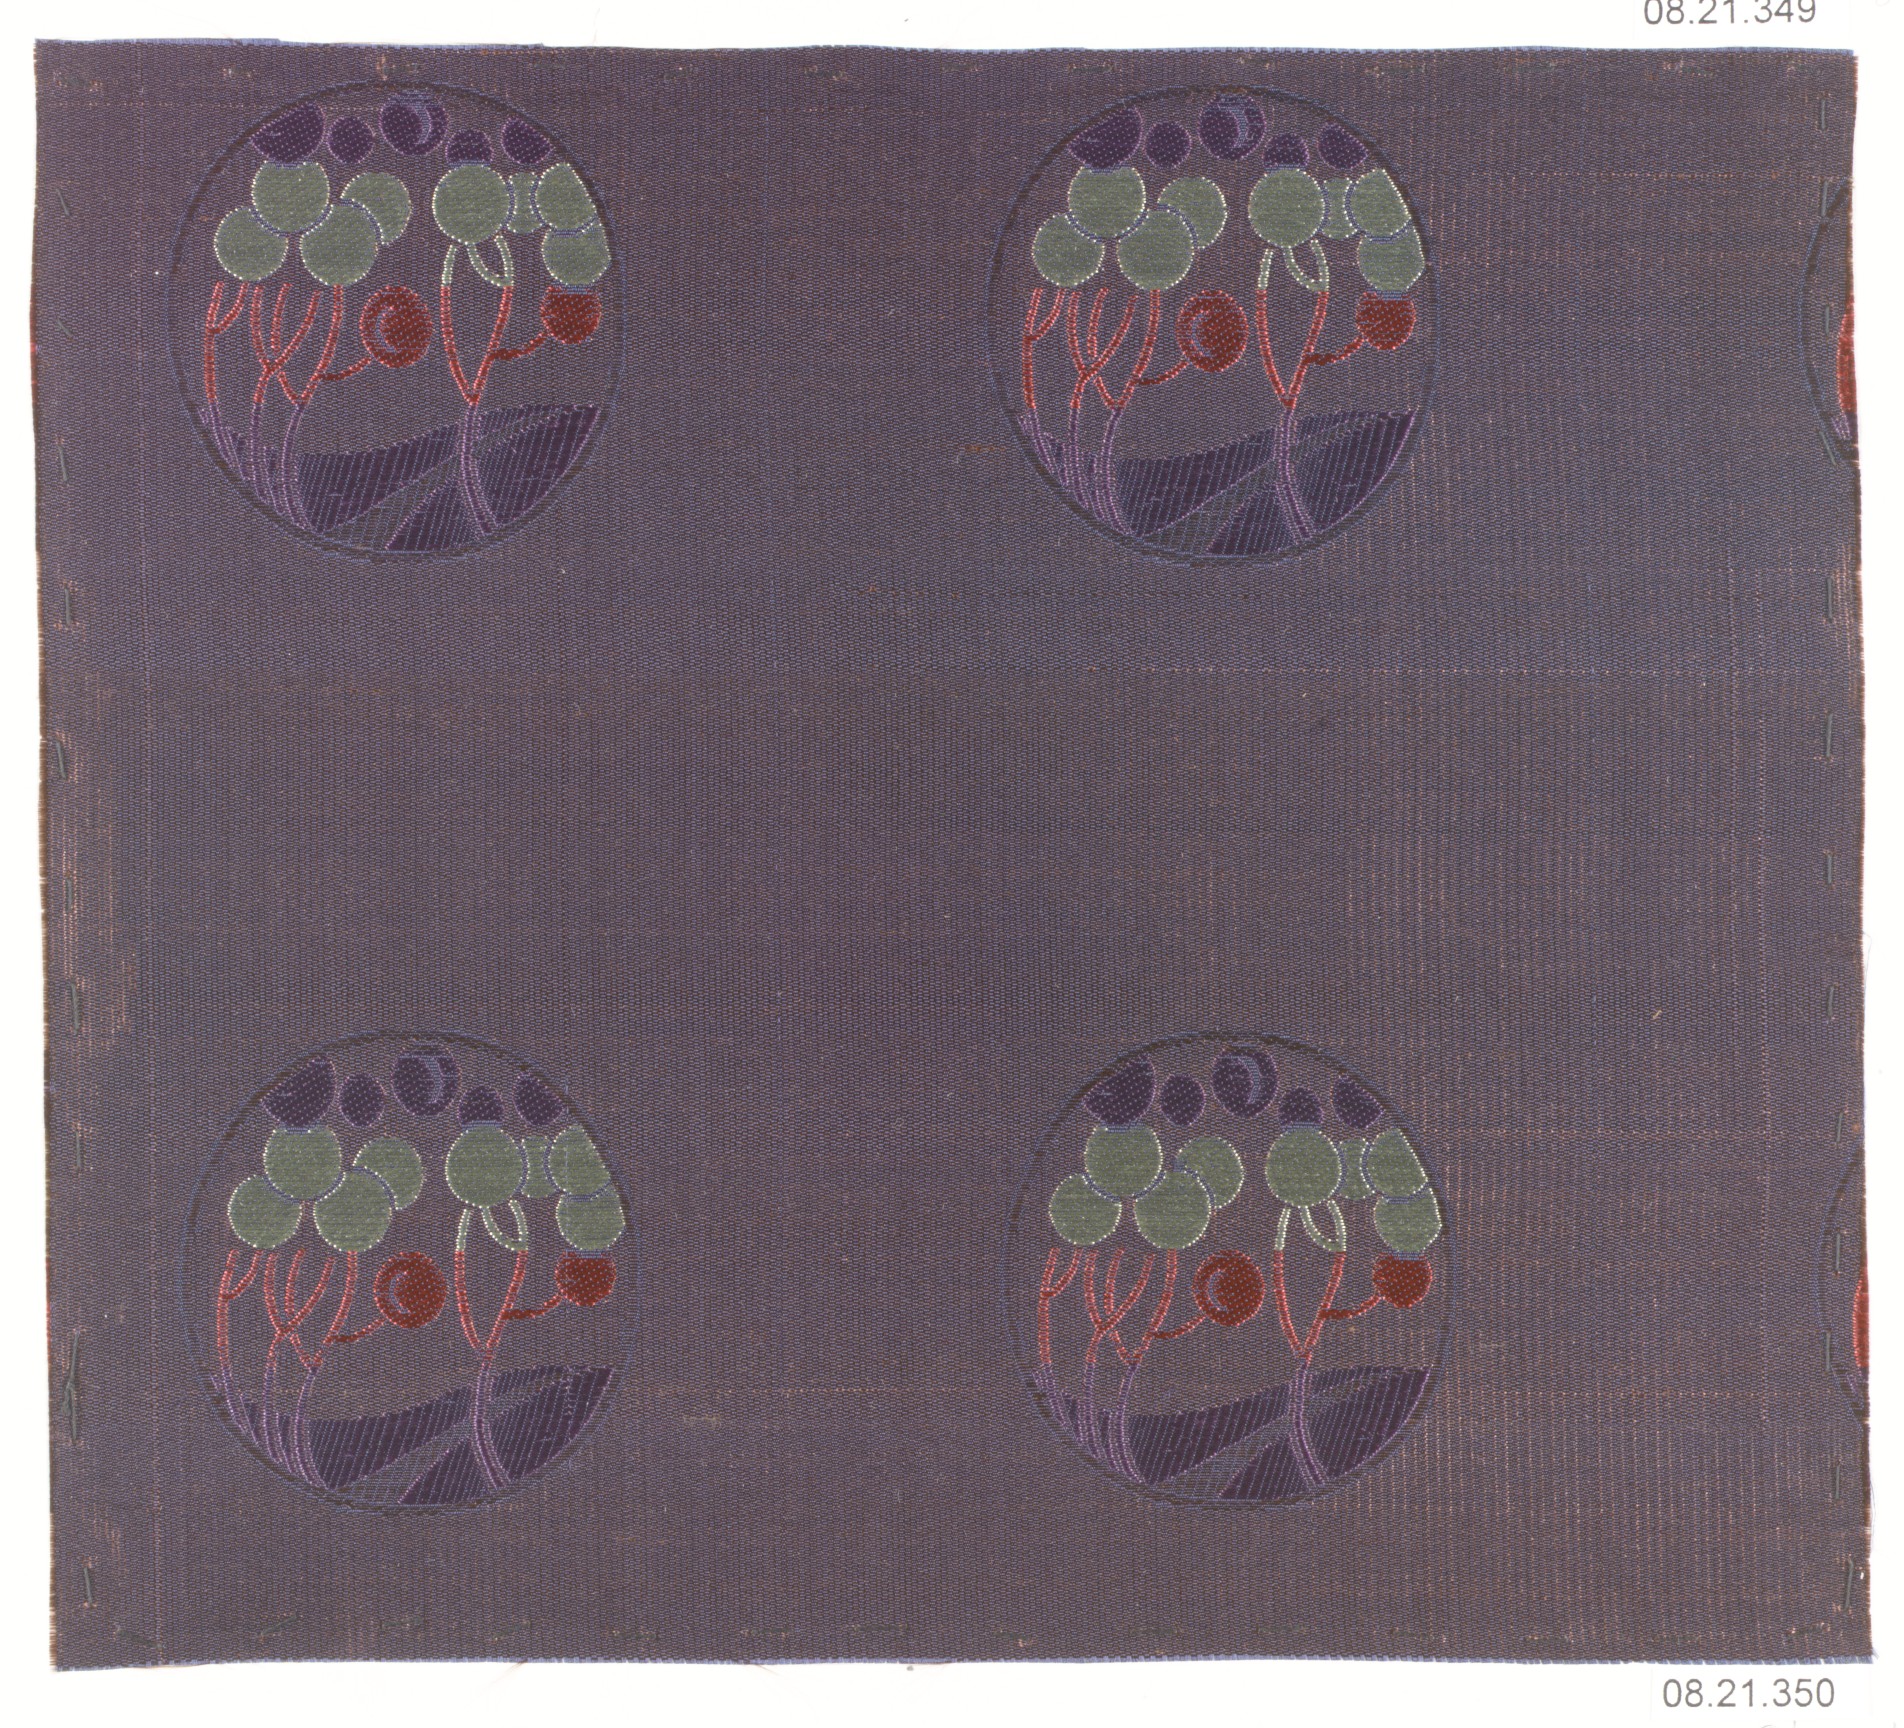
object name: textile sample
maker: Anonymous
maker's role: designer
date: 1900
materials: silk